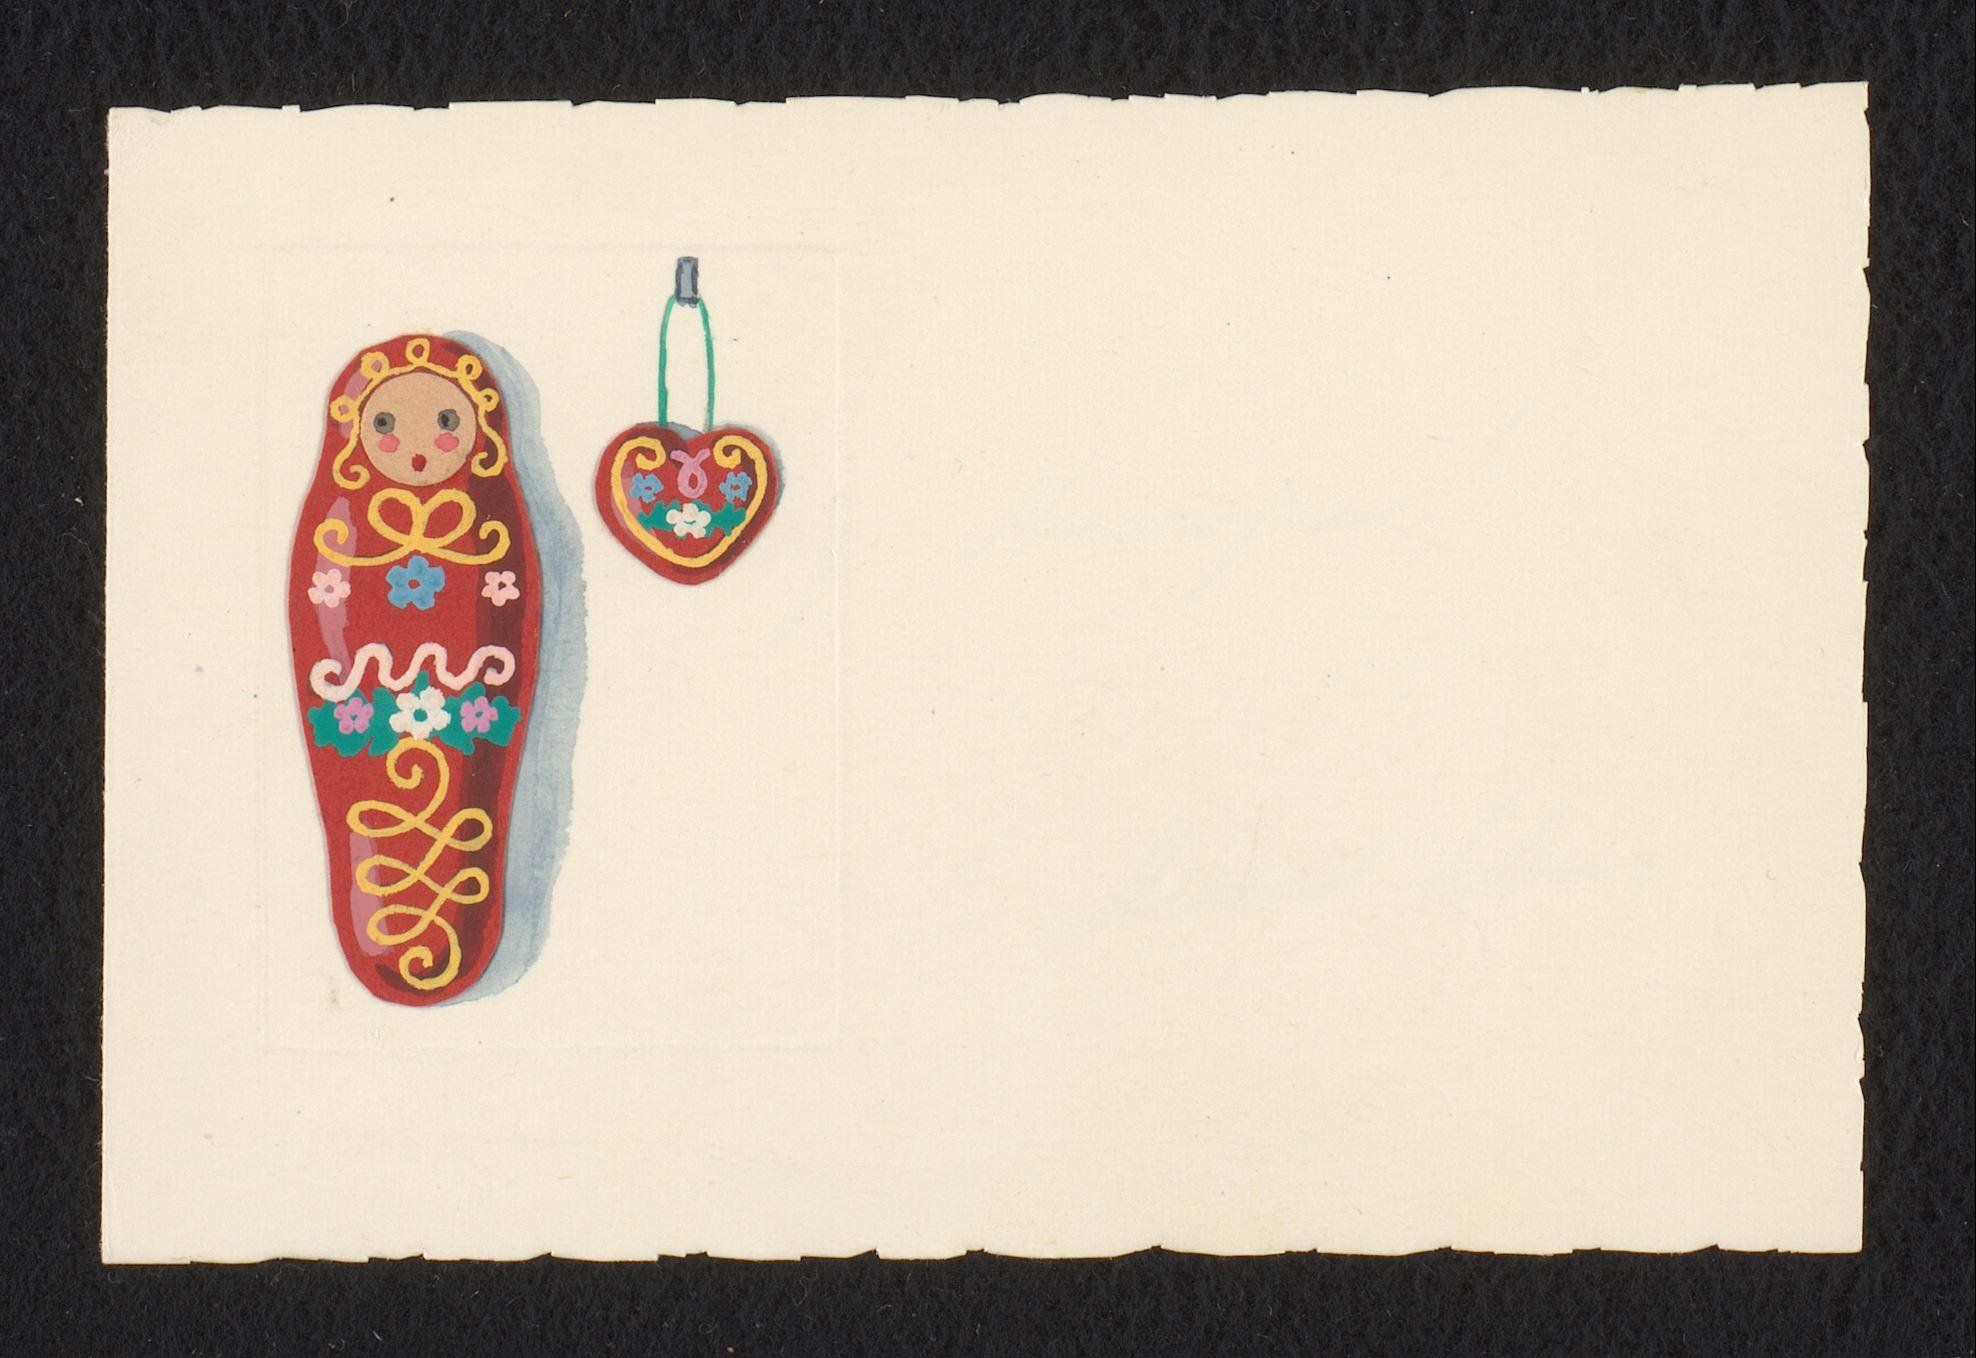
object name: christmas card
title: Nieuwjaarswens met pop en hart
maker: Anonymous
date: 1950-2000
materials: paper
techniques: brush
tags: christmas card, (playing with) dolls, fowl (cock, hen, chicken, etc.)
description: Op de voorzijde een pop en een hart aan een hanger. Binnenin in handschrift de tekst: 'Gelukkig Nieuwjaar!' en een onleesbare handtekening.